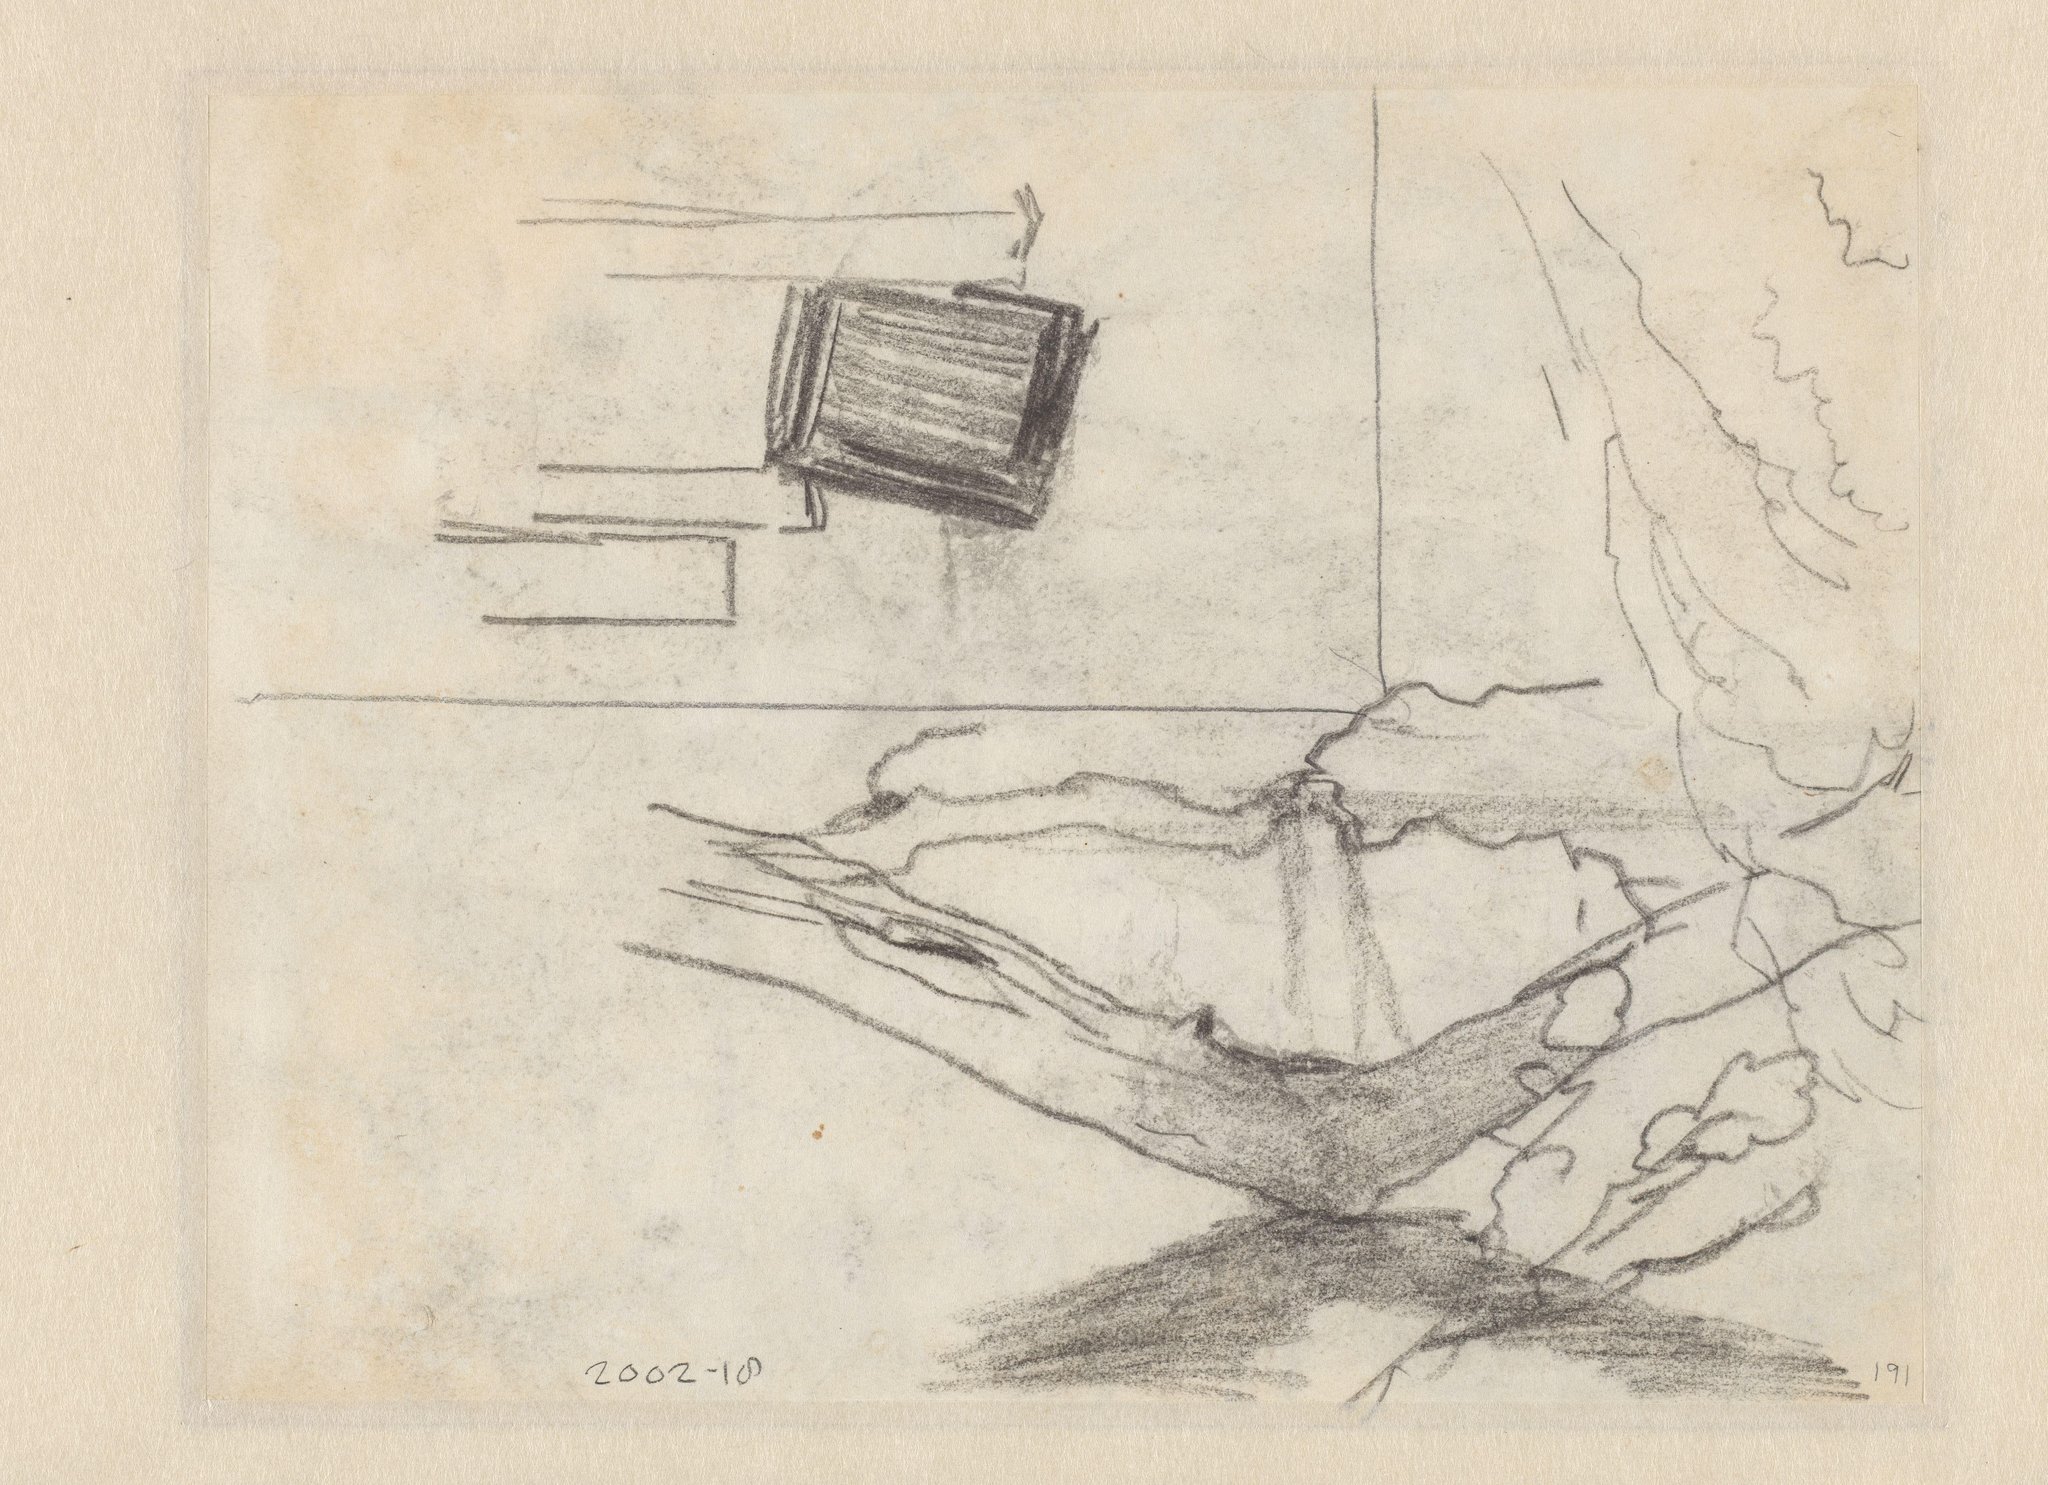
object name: drawing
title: Boomstudie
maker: matthijs maris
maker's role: draughtsman, painter, print maker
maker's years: 1839-1917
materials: chalk, paper